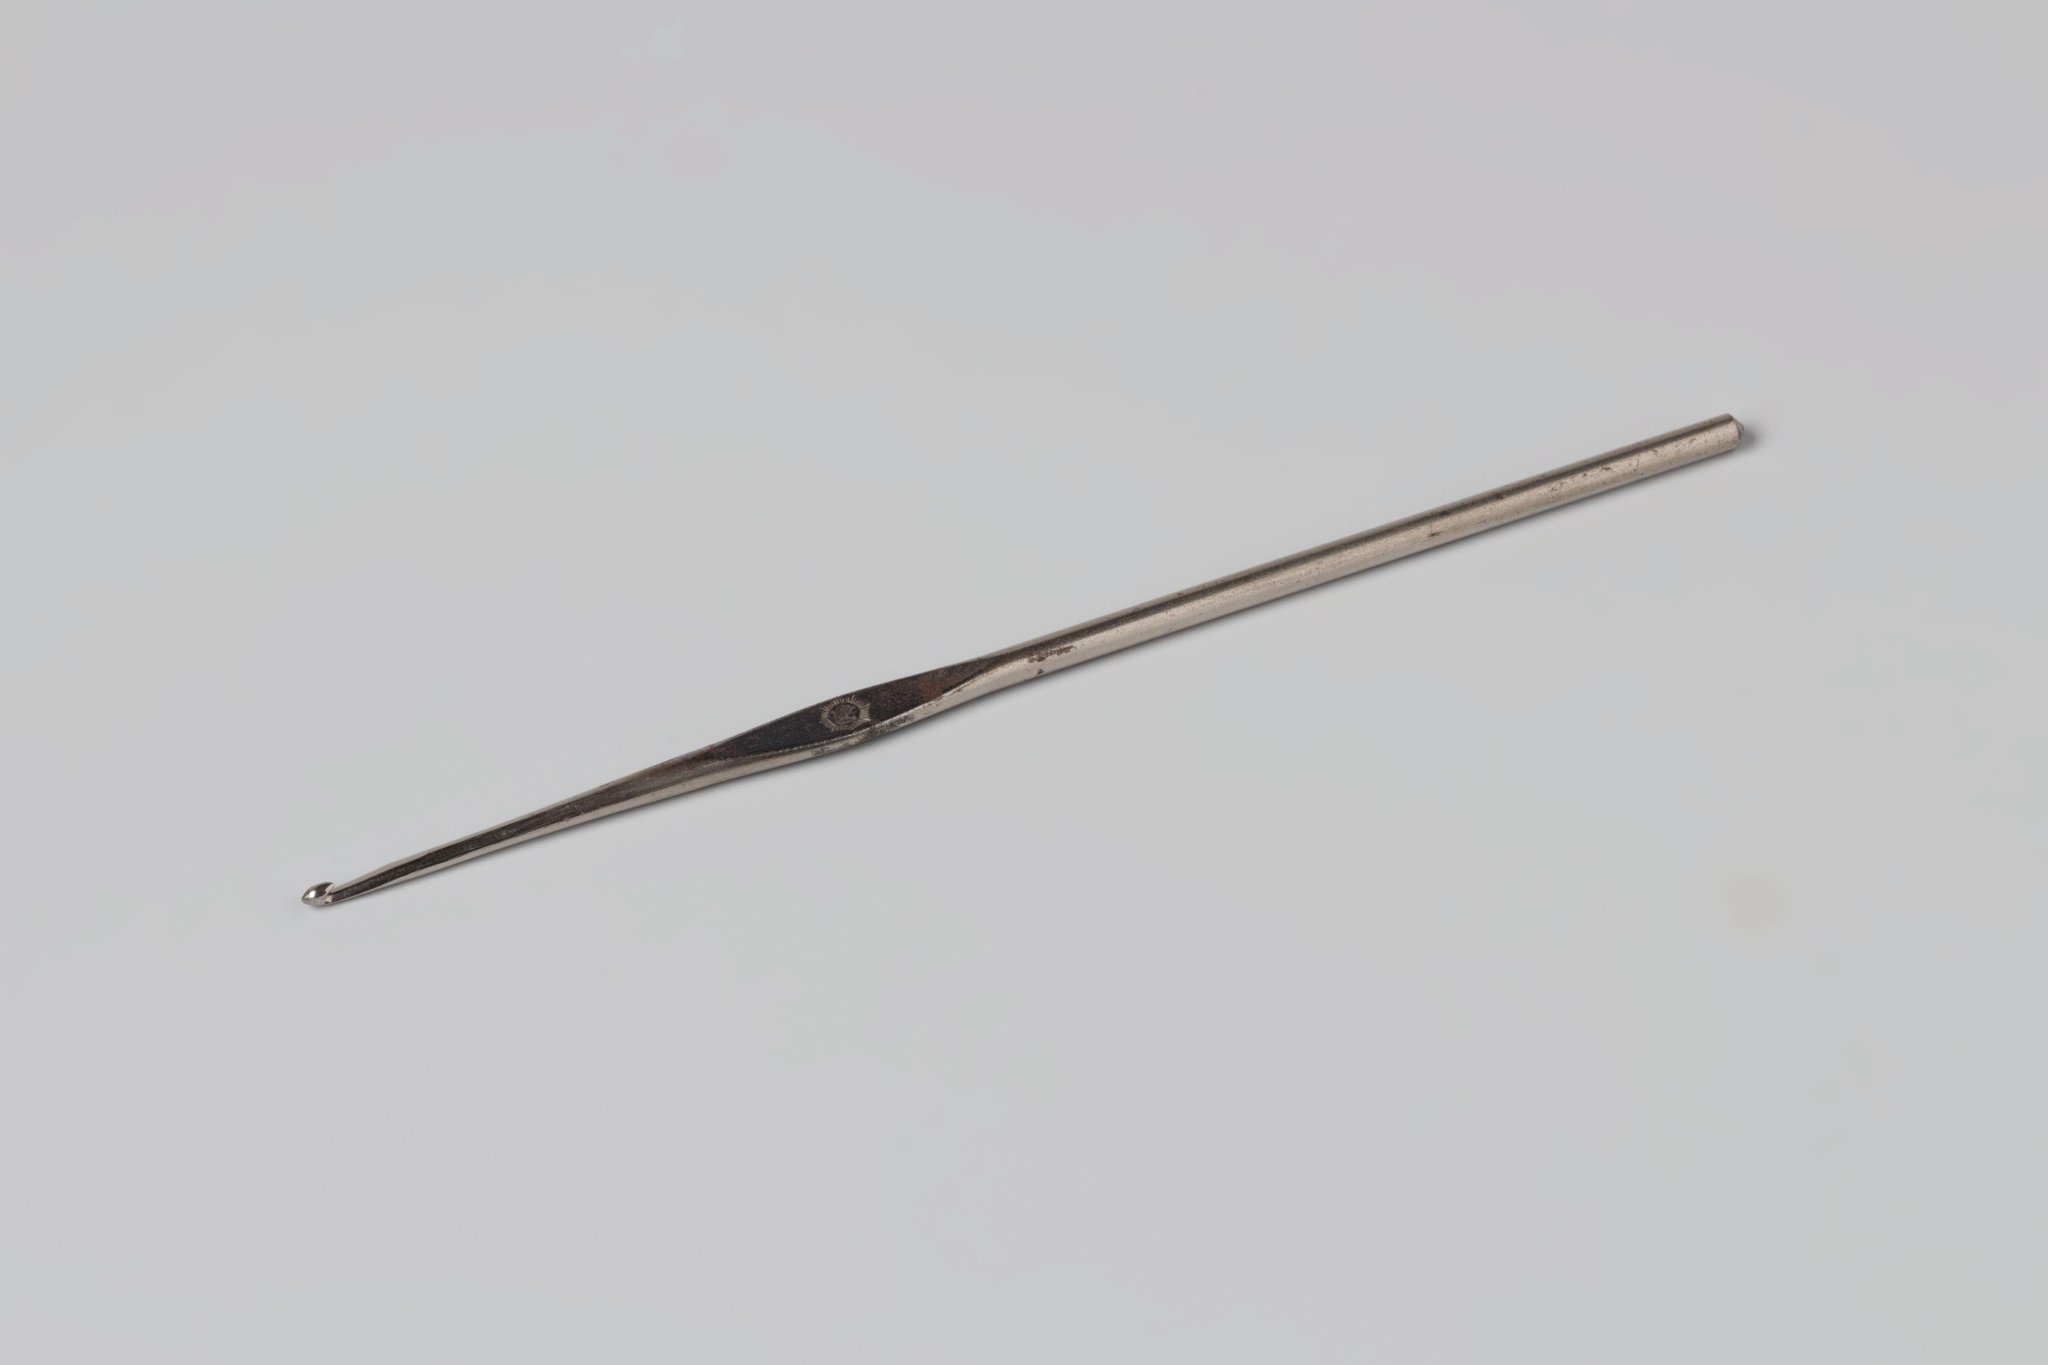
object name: textile working equipment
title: Haakpen van staal met afgeplat handvat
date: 1900-1950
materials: steel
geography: germany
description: Een haakpen van staal met afgeplat handvat.